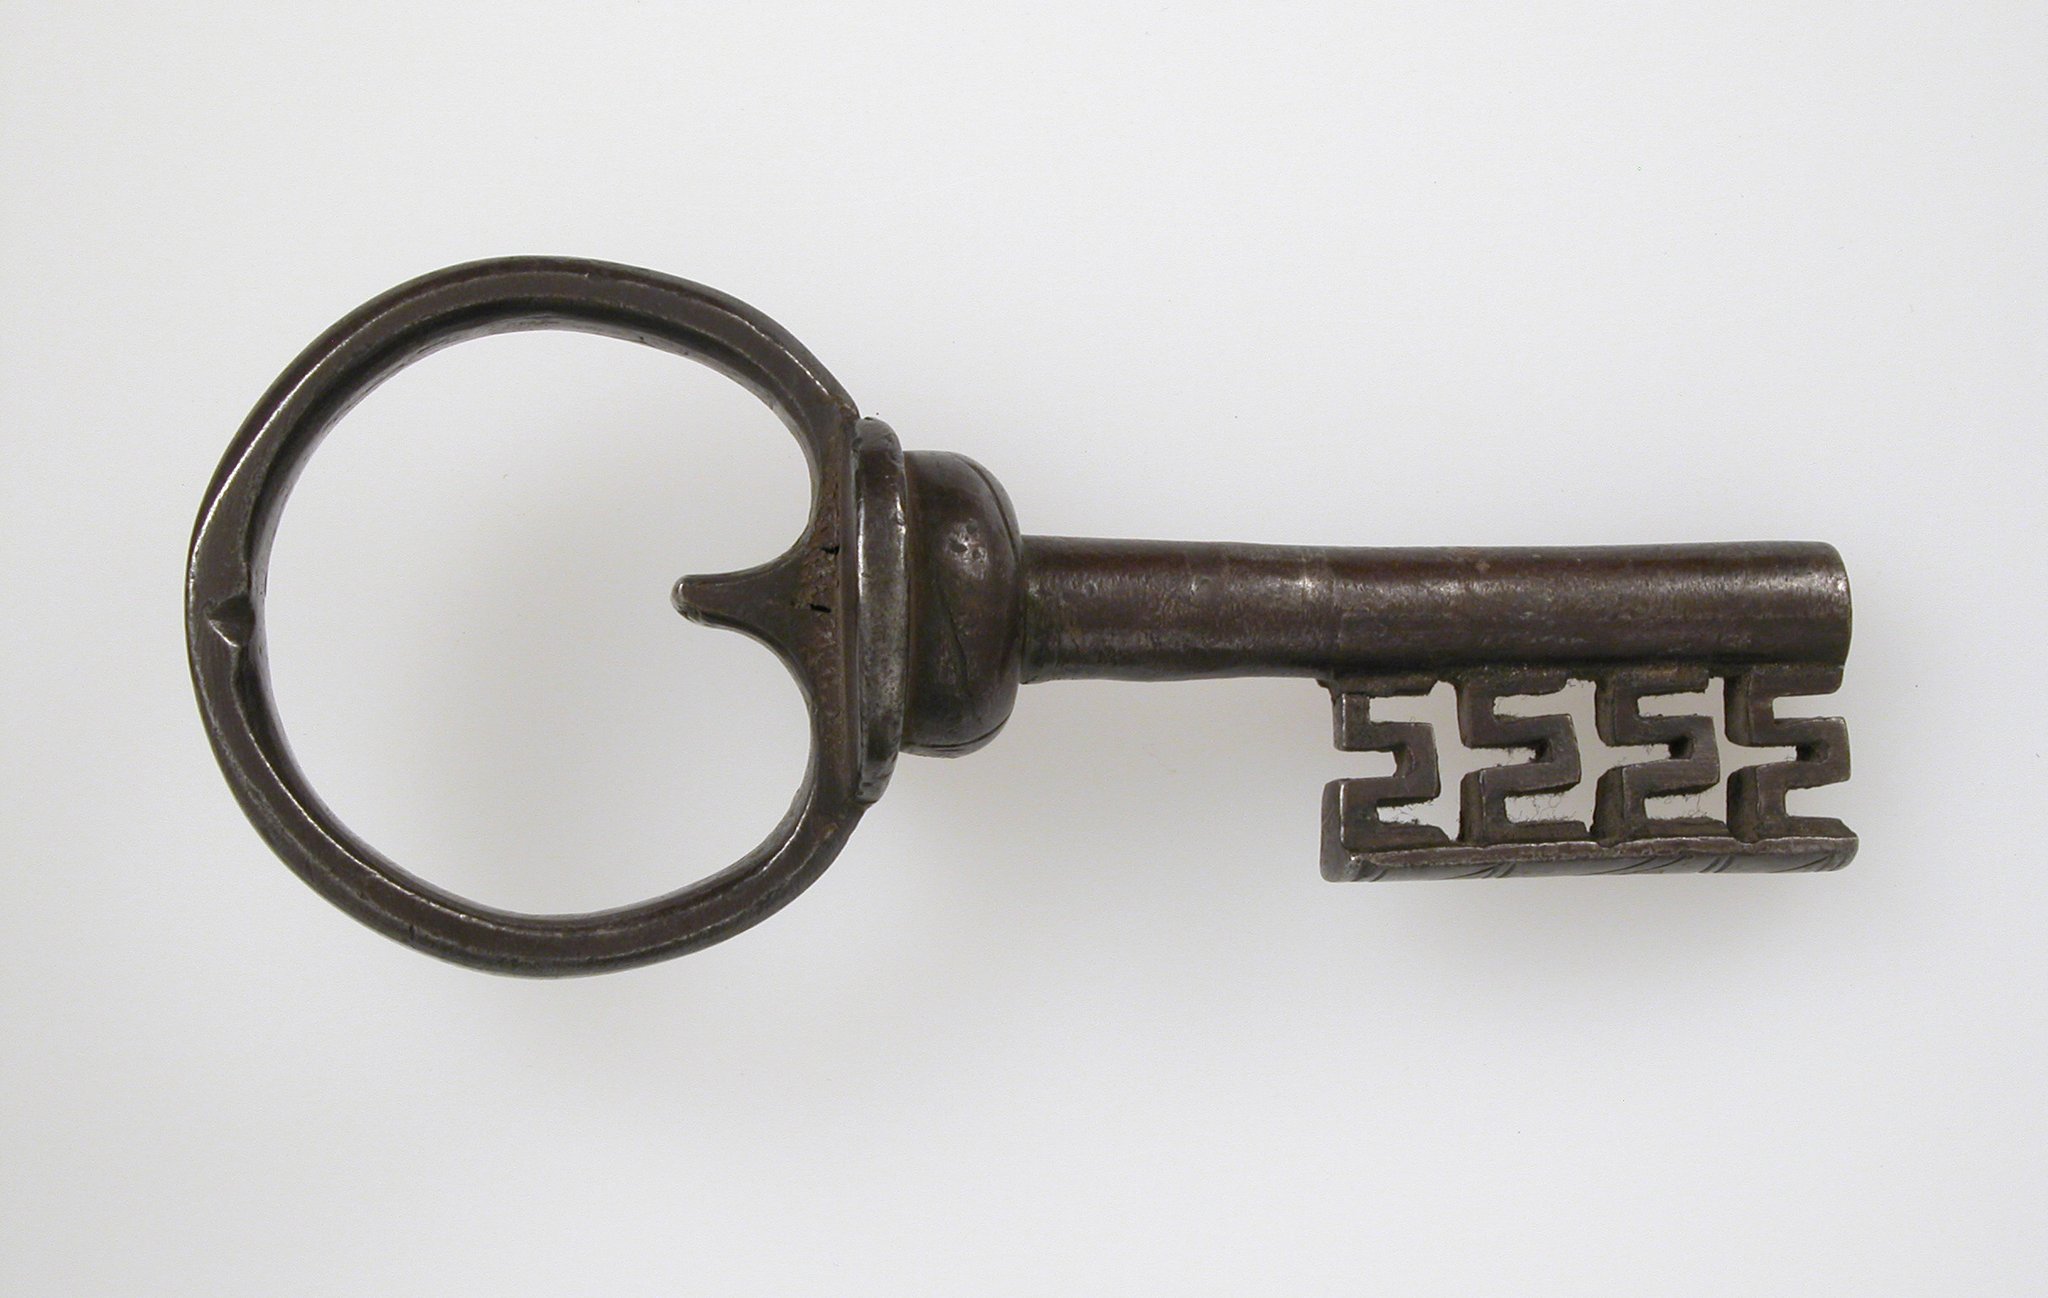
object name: key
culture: german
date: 1401-1600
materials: iron